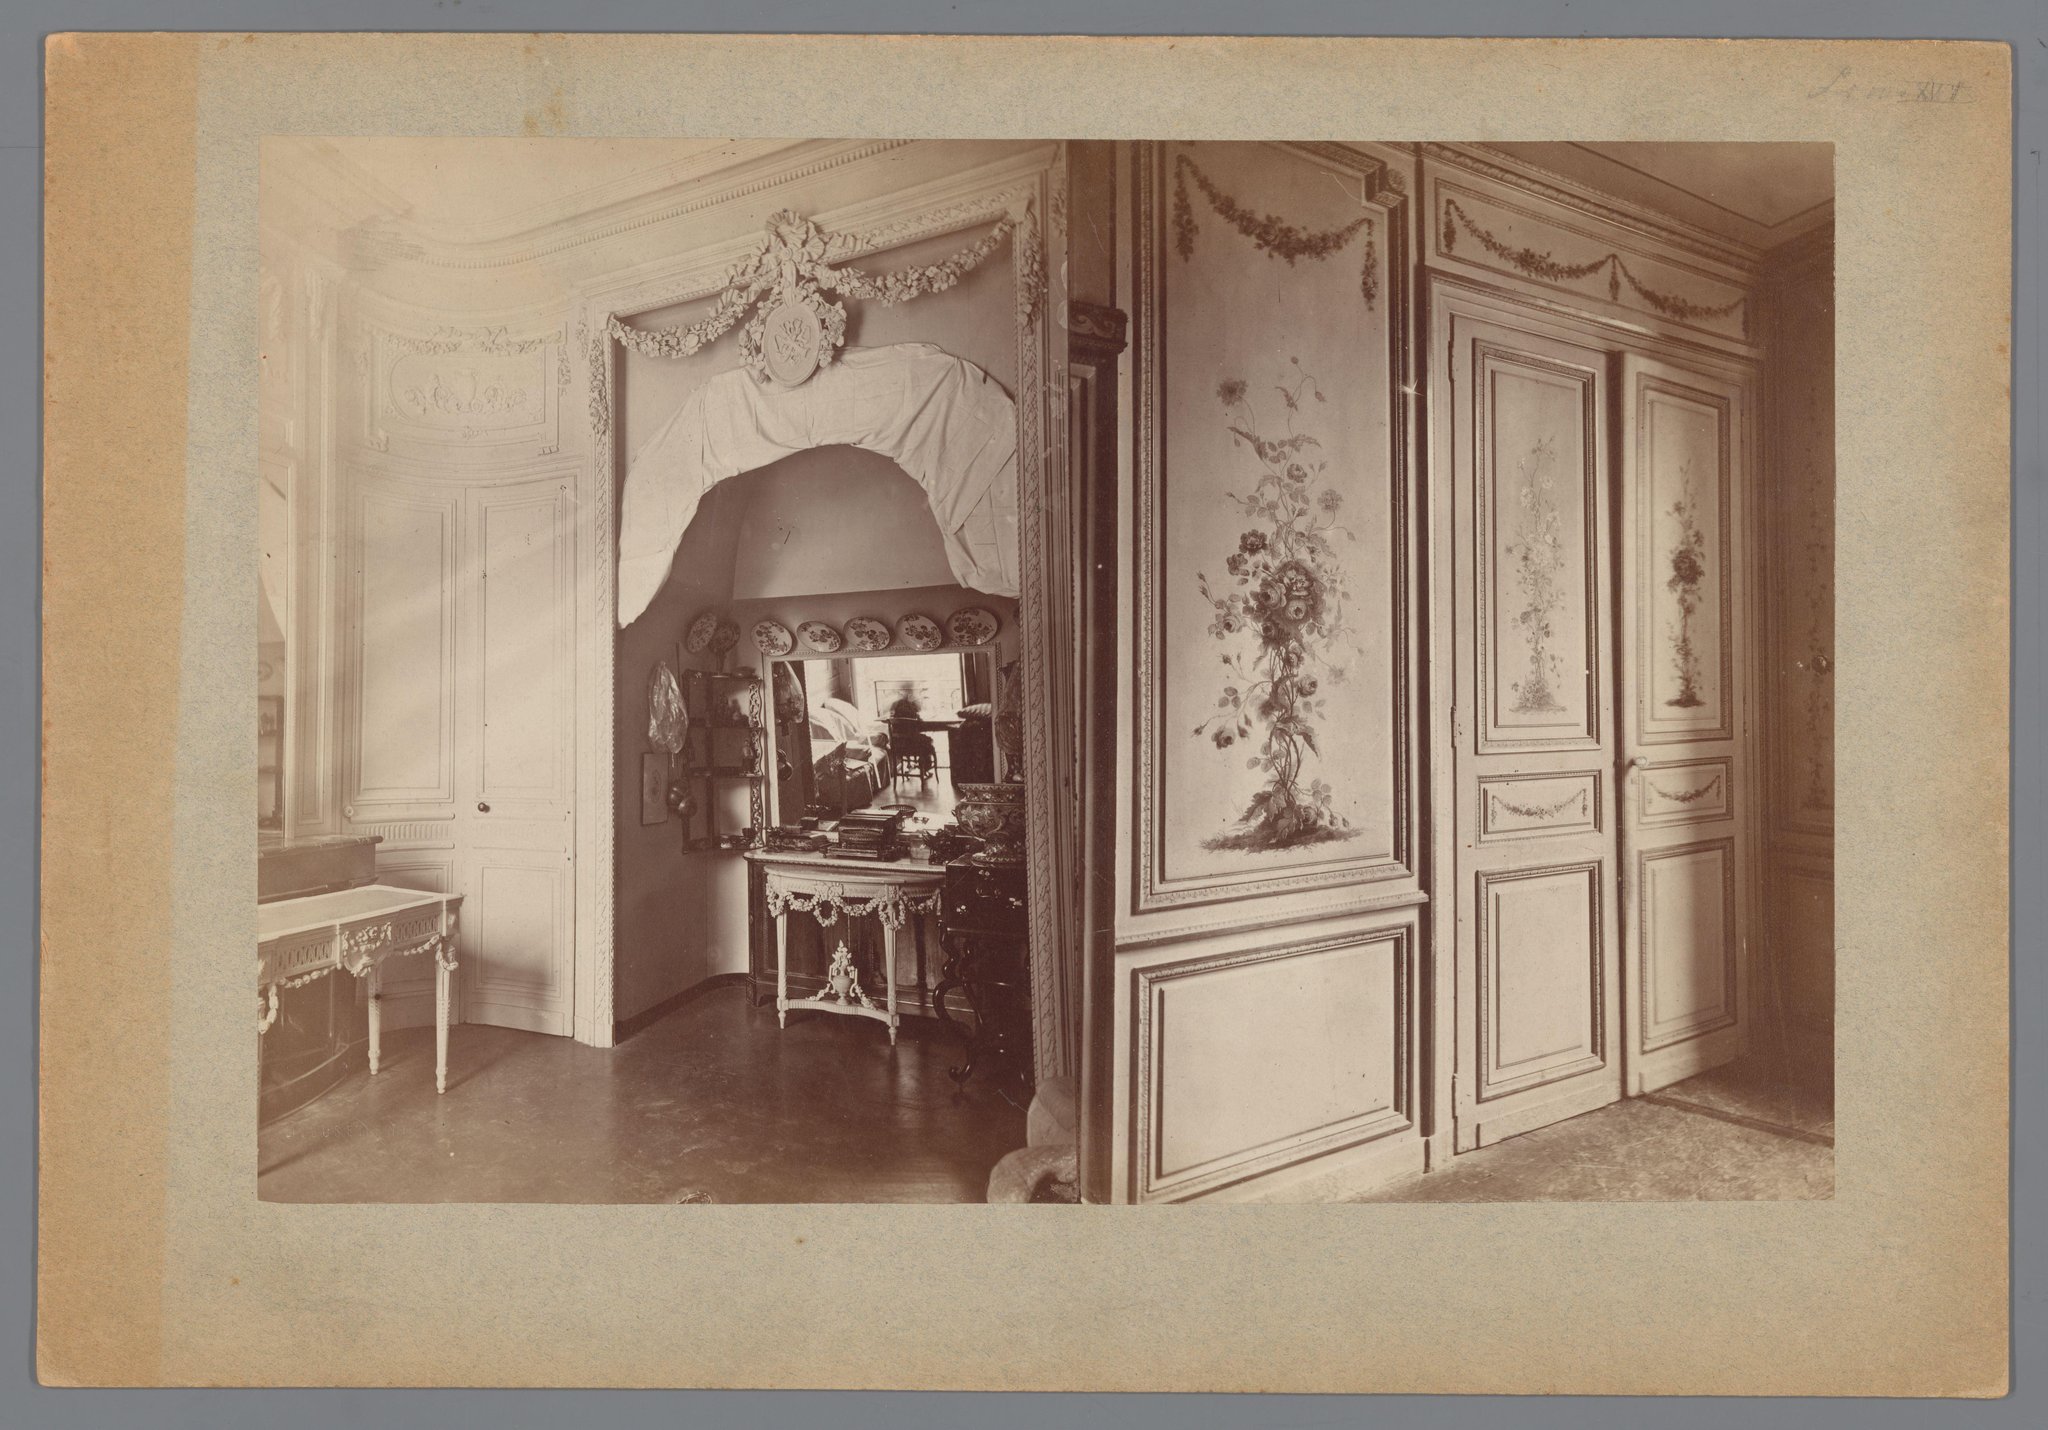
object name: photograph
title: Twee interieurs met een schrijftafel en beschilderde deuren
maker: séraphin-médéric mieusement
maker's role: fotograaf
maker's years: 1840-1905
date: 1875-1900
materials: cardboard, photographic support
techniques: albumen print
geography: europe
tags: writing-table, writing-desk, interior ~ representation of a building, closed door, flowers ~ ornament, europe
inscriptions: inscription: ‘MONUMENTS HISTORIQUES’, name: ‘KUNSTBOEKHANDEL J. A. G. DE LEUR PHOTOGRAAF-UITGEVER Huigenspark, 40b. DEN HAAG.’, name: ‘MIEUSEMENT PHOTOGRAPHE’, inscription: ‘Louis XVI’, collector's mark: Lugt 3937